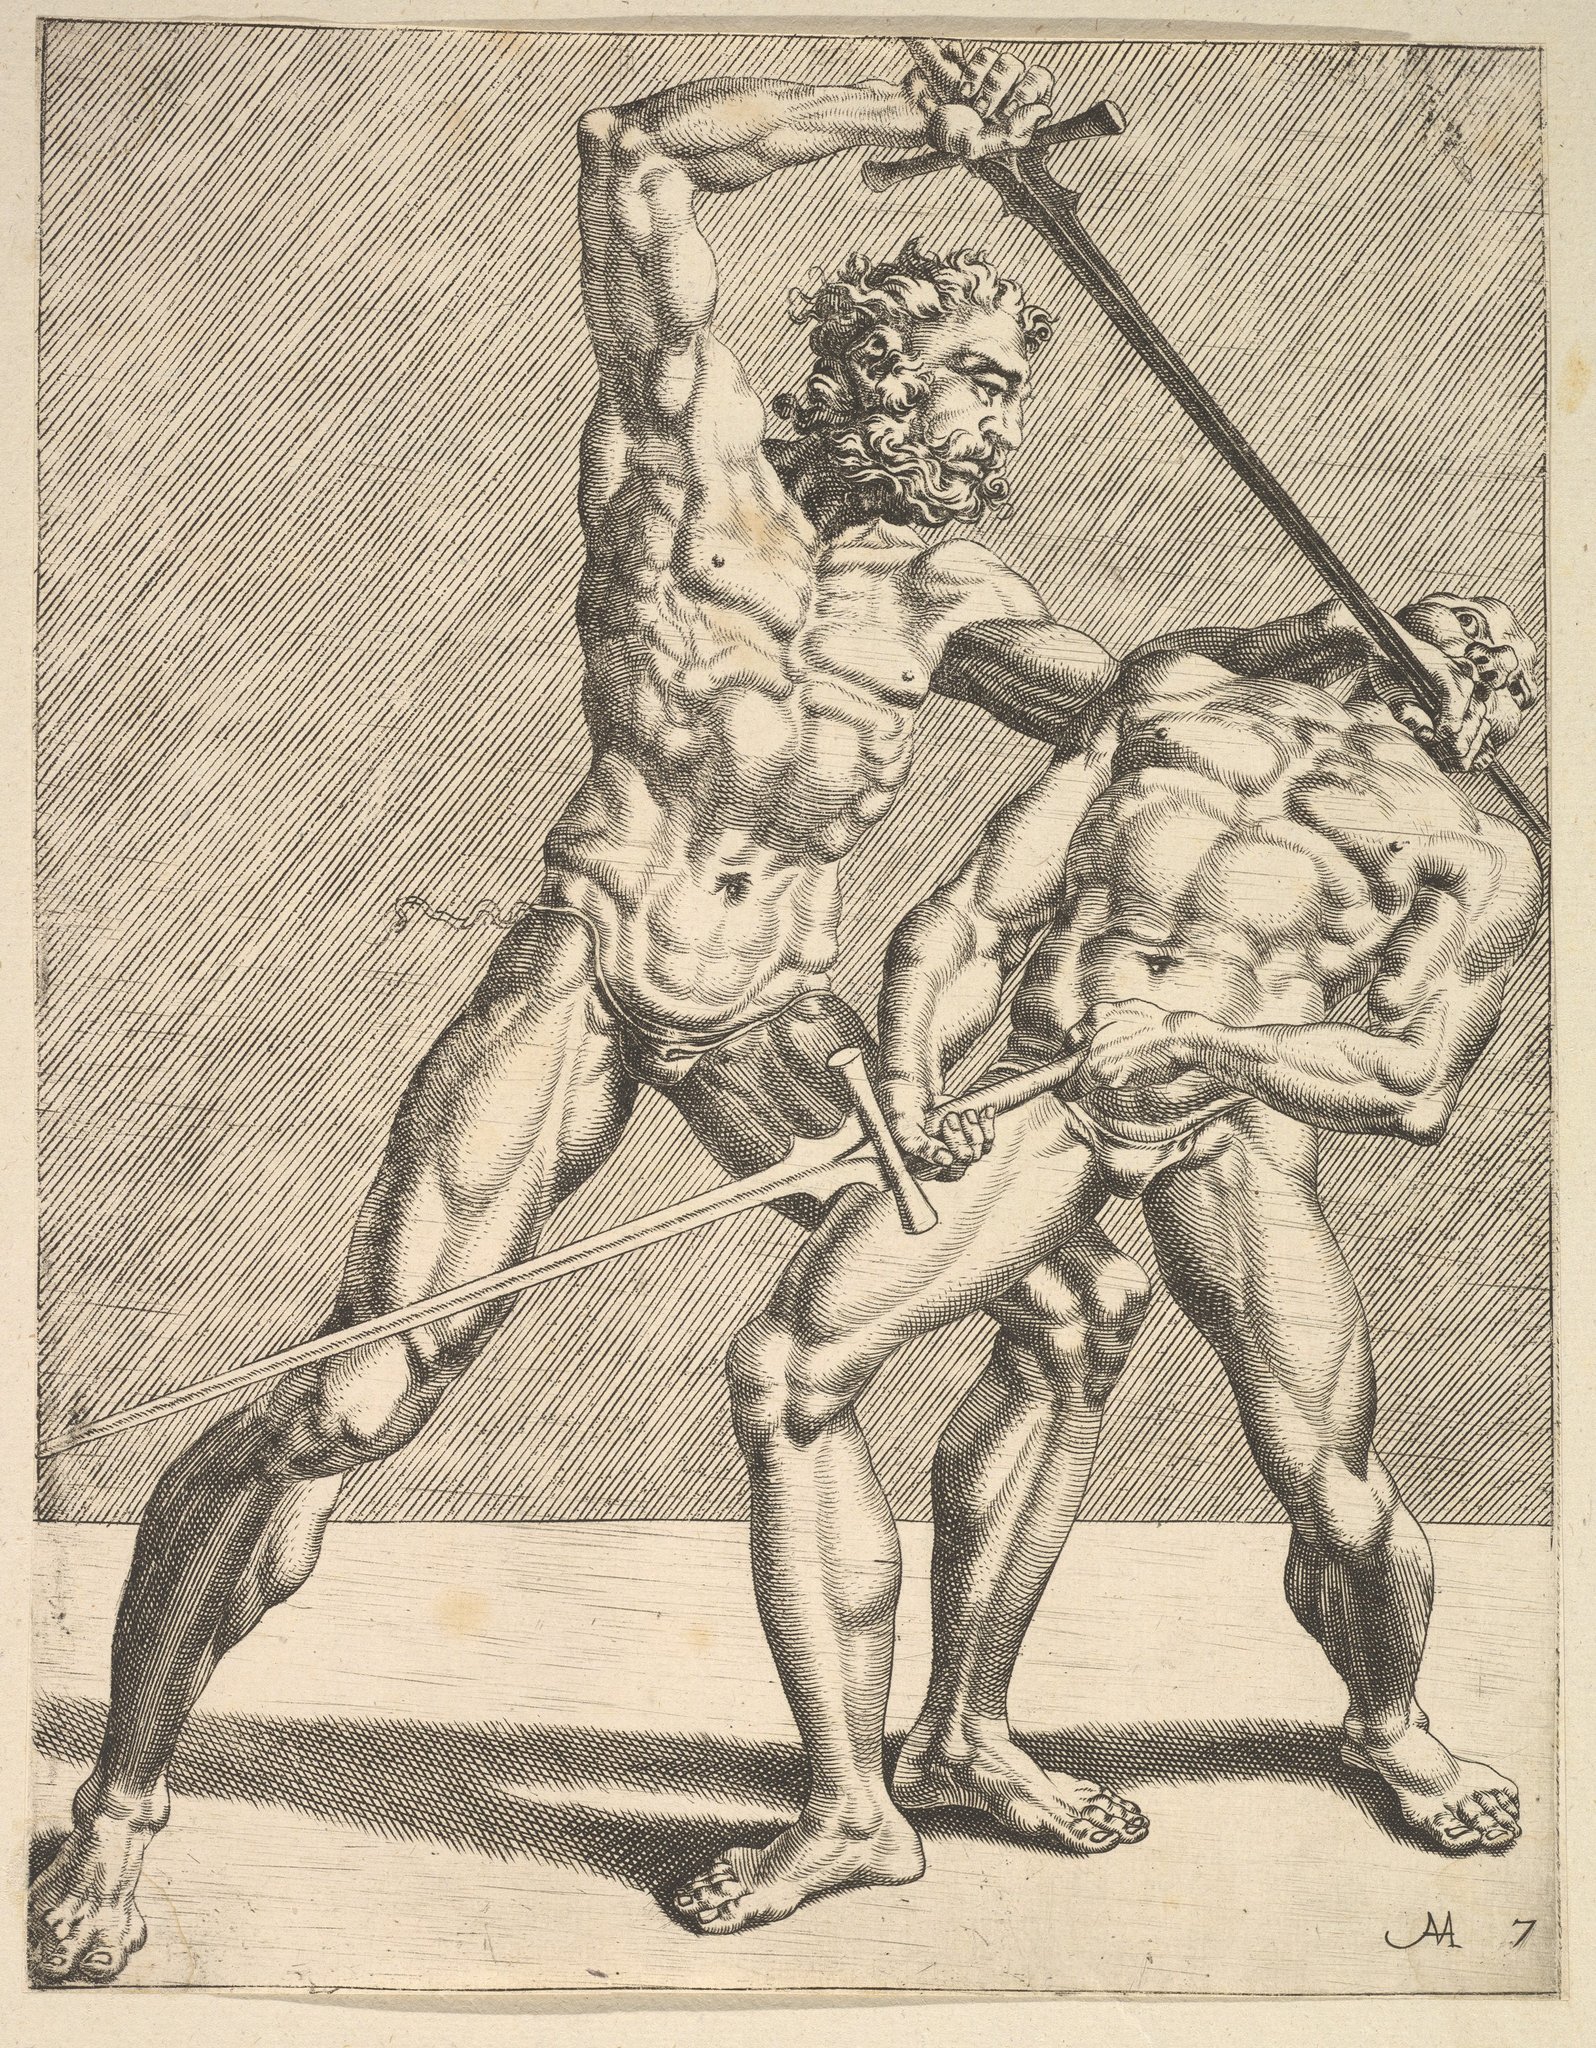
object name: print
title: Two Fencers, from Fencers, plate 7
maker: dirck volckertsz coornhert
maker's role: artist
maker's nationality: netherlandish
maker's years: 1519-1590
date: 1552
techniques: engraving, etching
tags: swords,men,male nudes,athletes,fencing